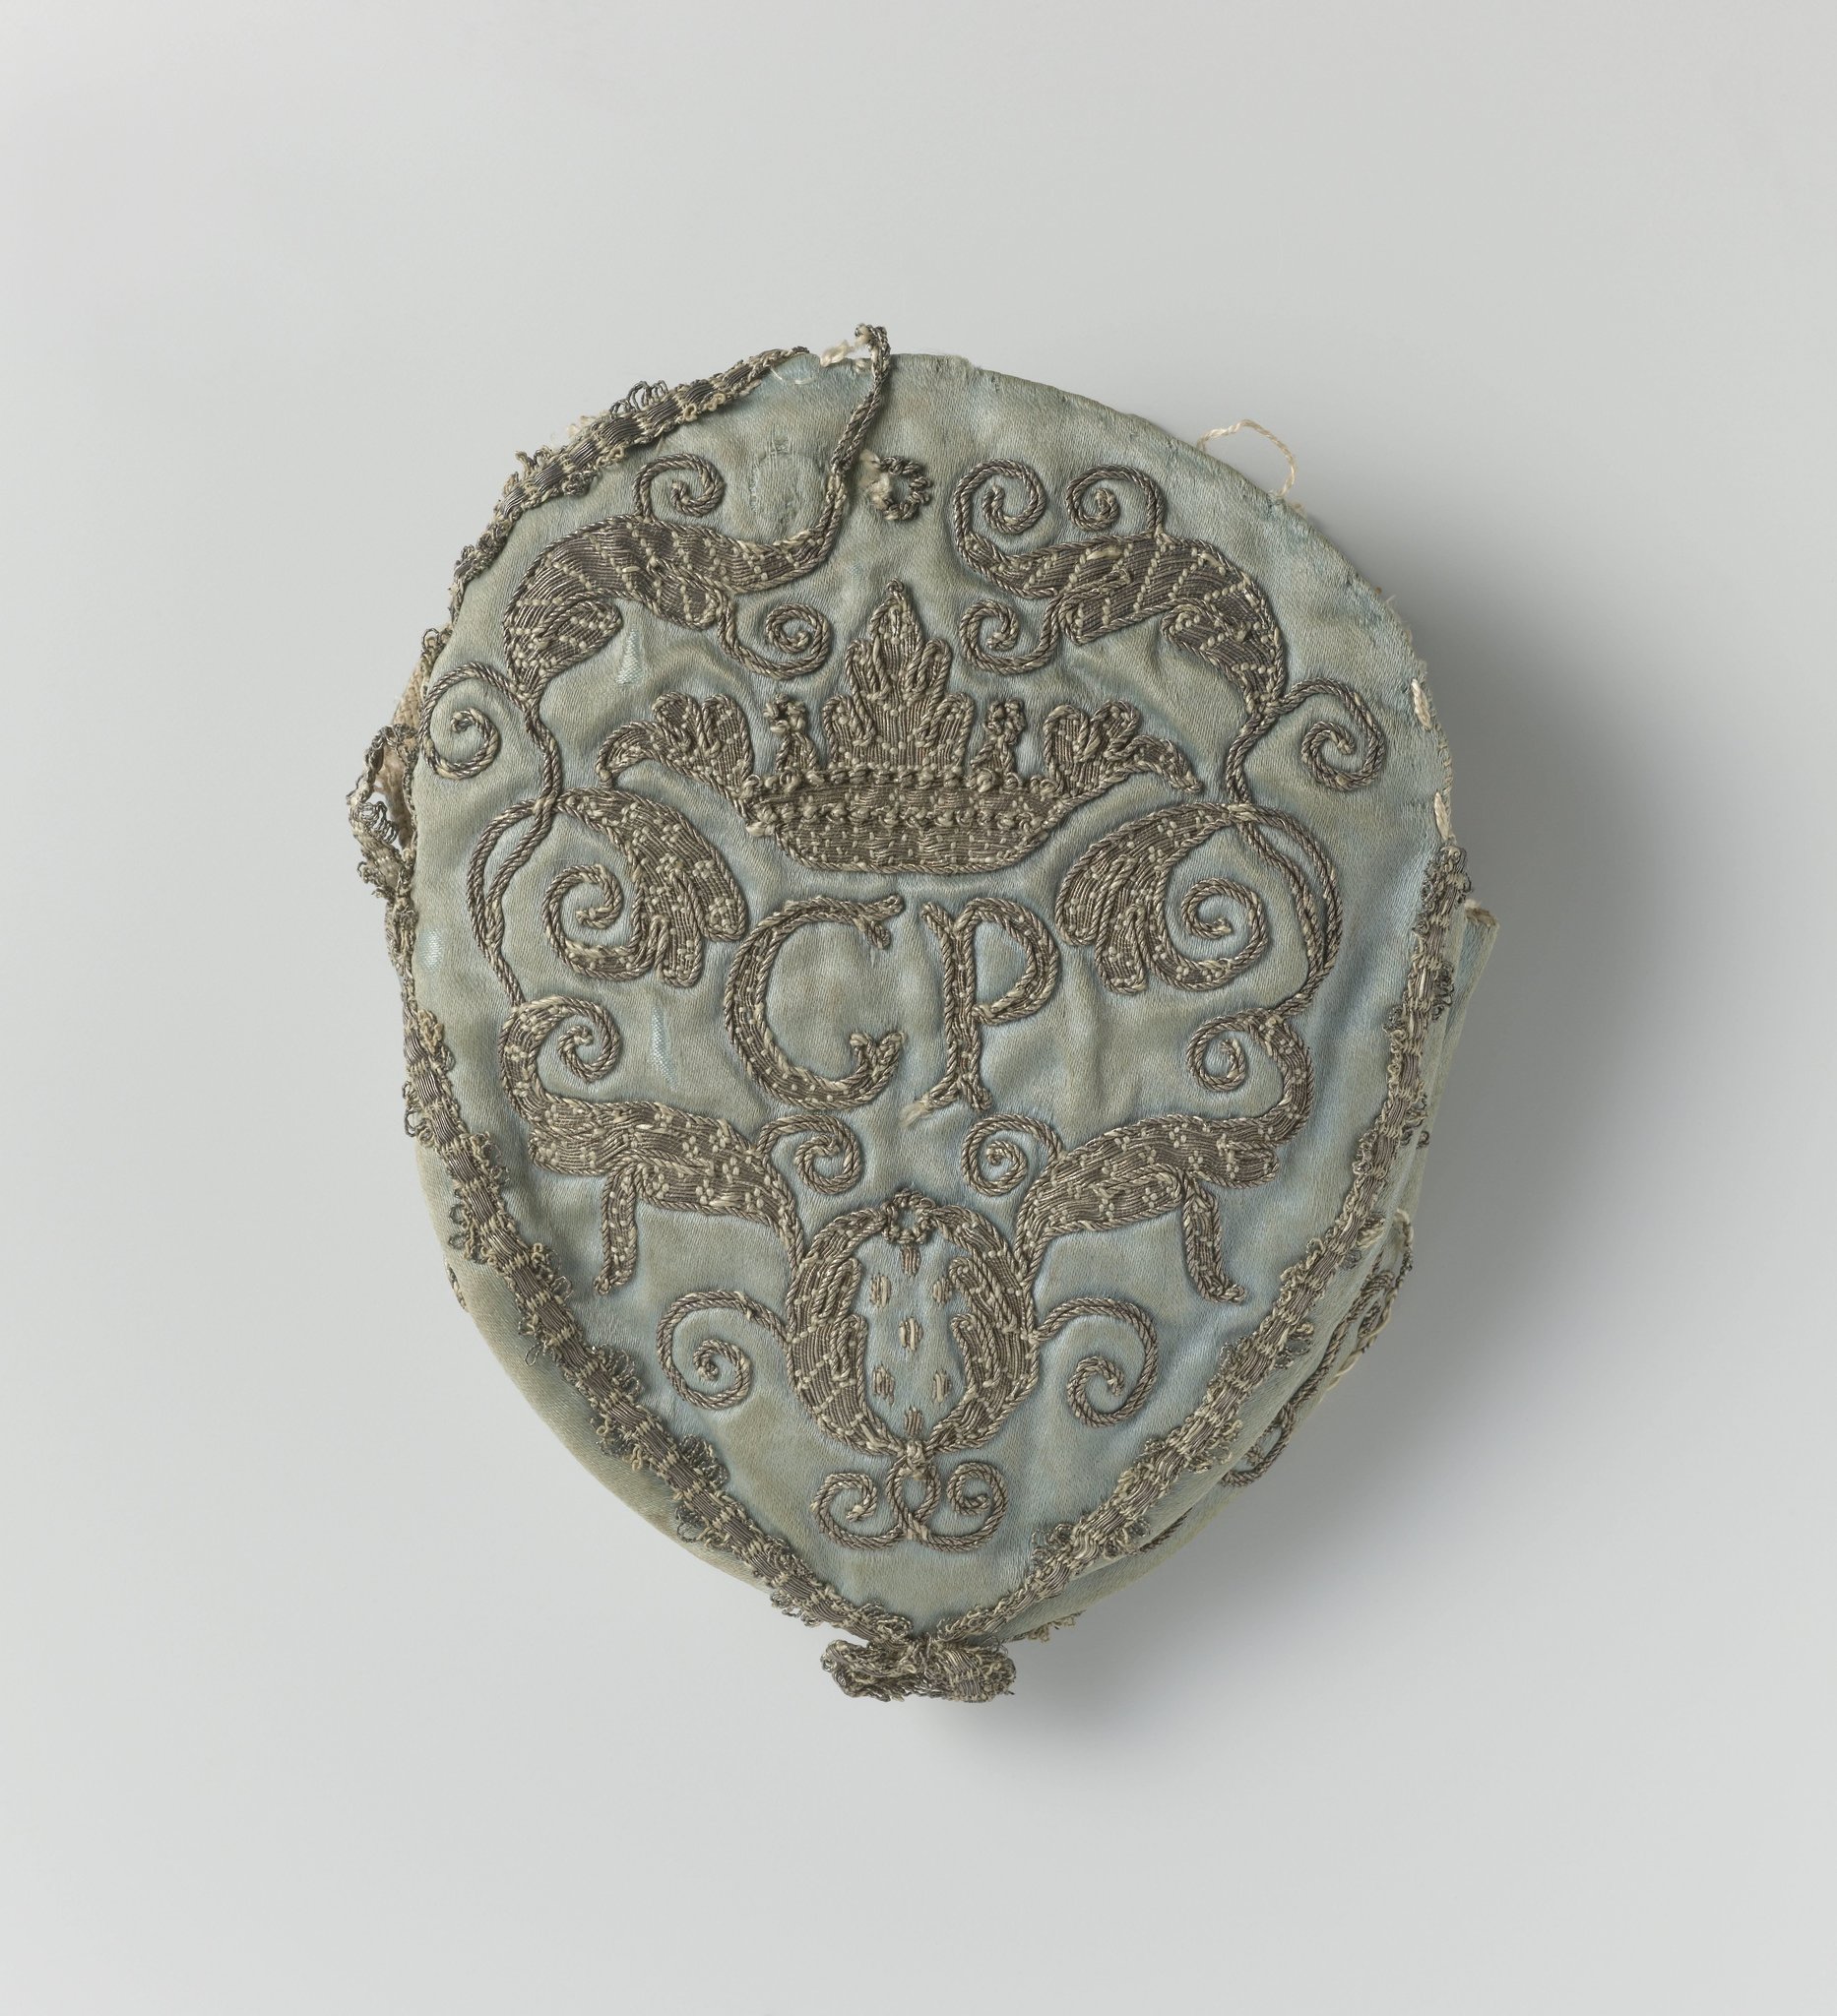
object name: bag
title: Tas van lichtblauwe zijde, met zilverdraad geborduurd, letters C P waarboven een kroon, omgeven door ornamenten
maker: Anonymous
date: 1700-1800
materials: linen, silk, thread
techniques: embroidered, weave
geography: netherlands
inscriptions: initials: ‘'CP'’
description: Tasje van lichtblauwe zijde, met zilverdraad geborduurd. Letters C P waarboven een kroon, omgeven door ornamenten. Gevoerd met linnen.